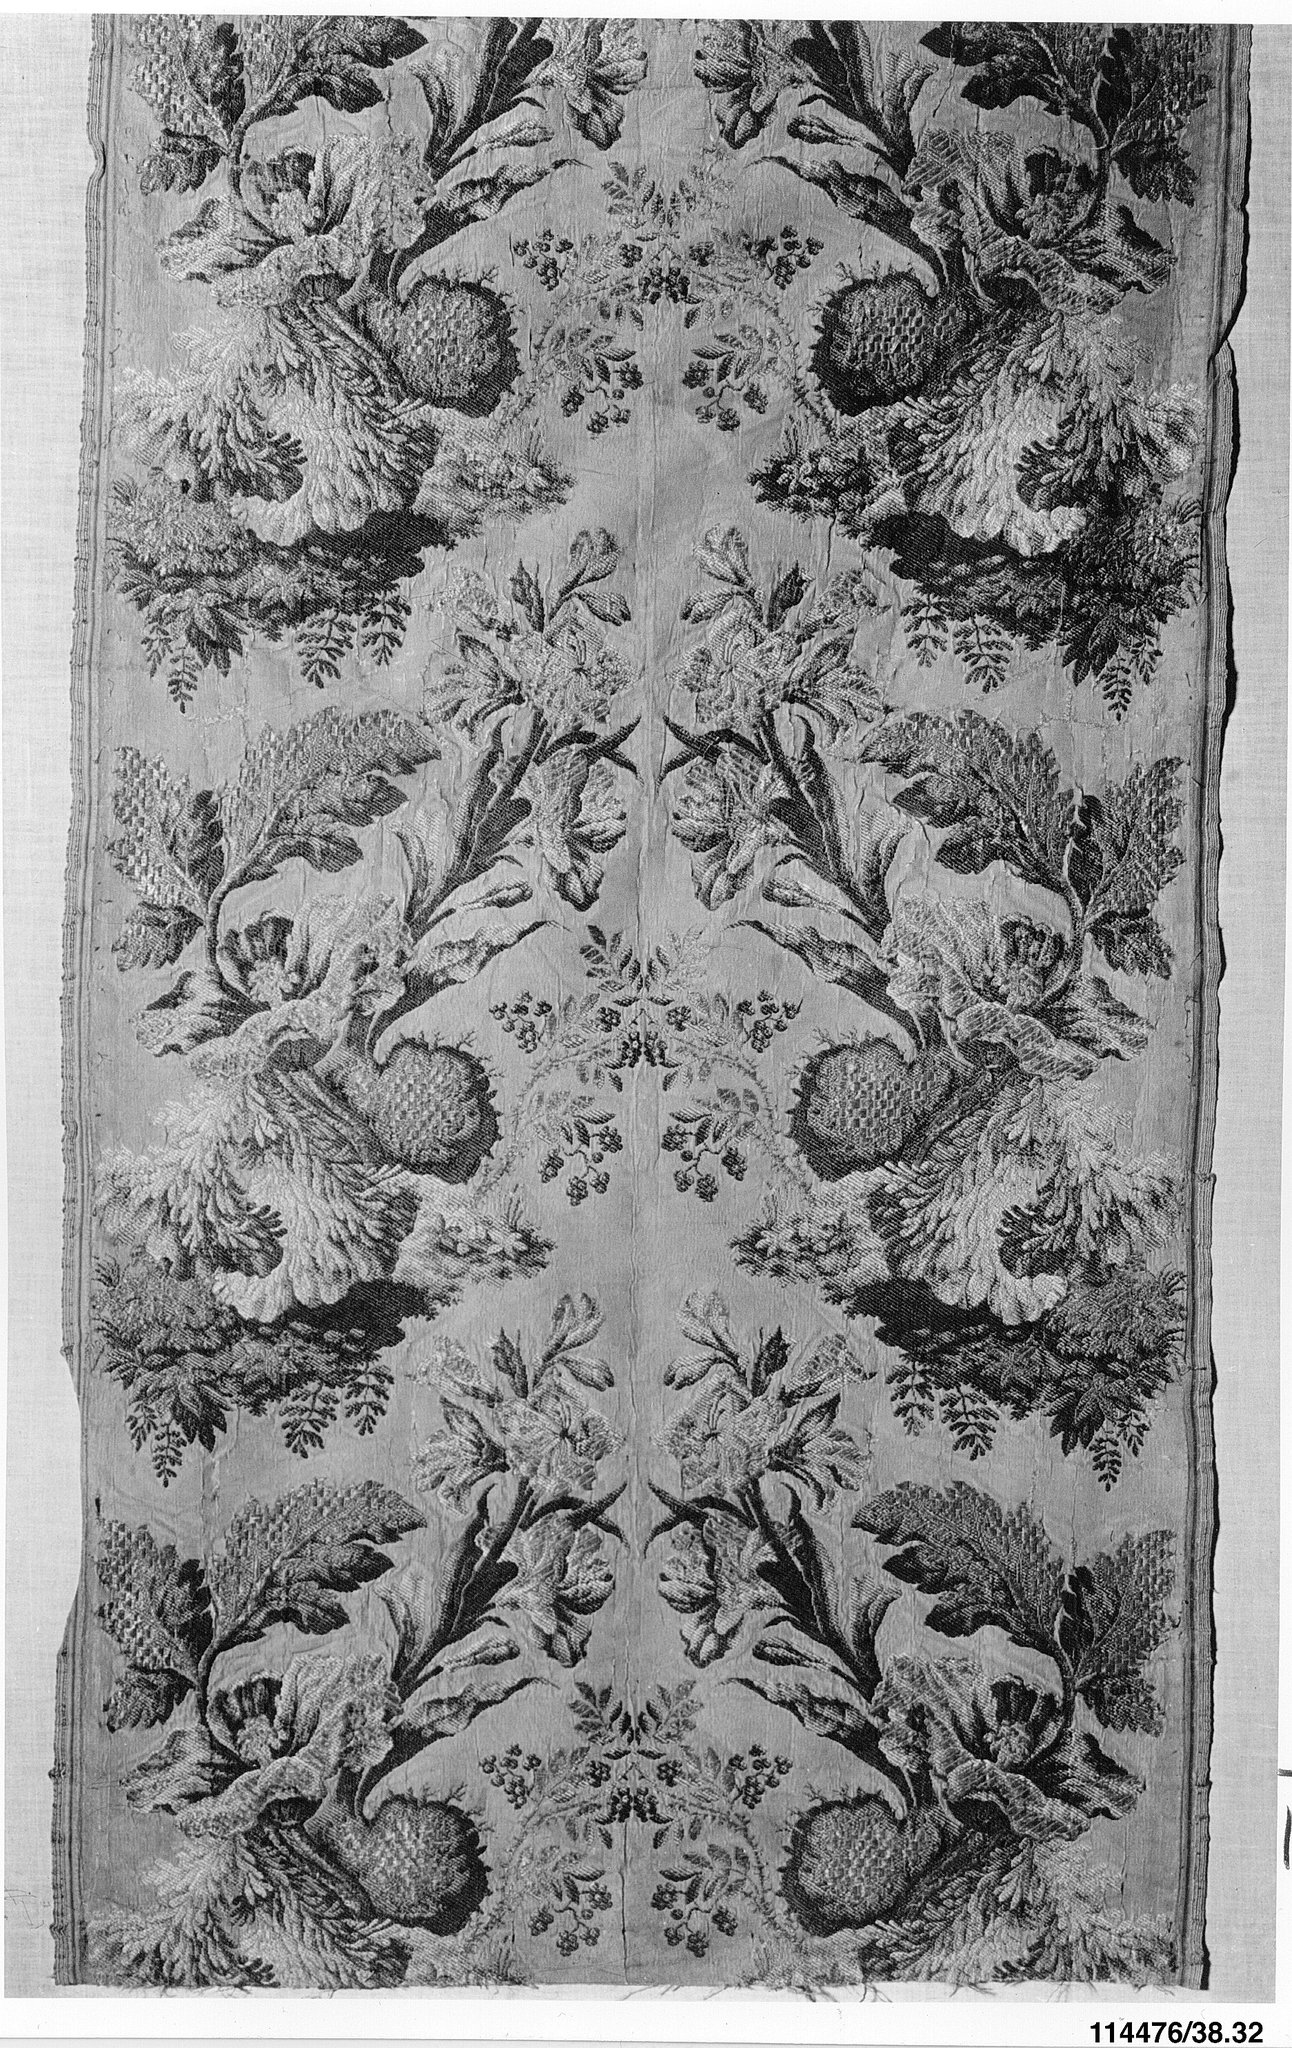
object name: piece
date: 1730-1735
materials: metal thread, silk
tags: leaves